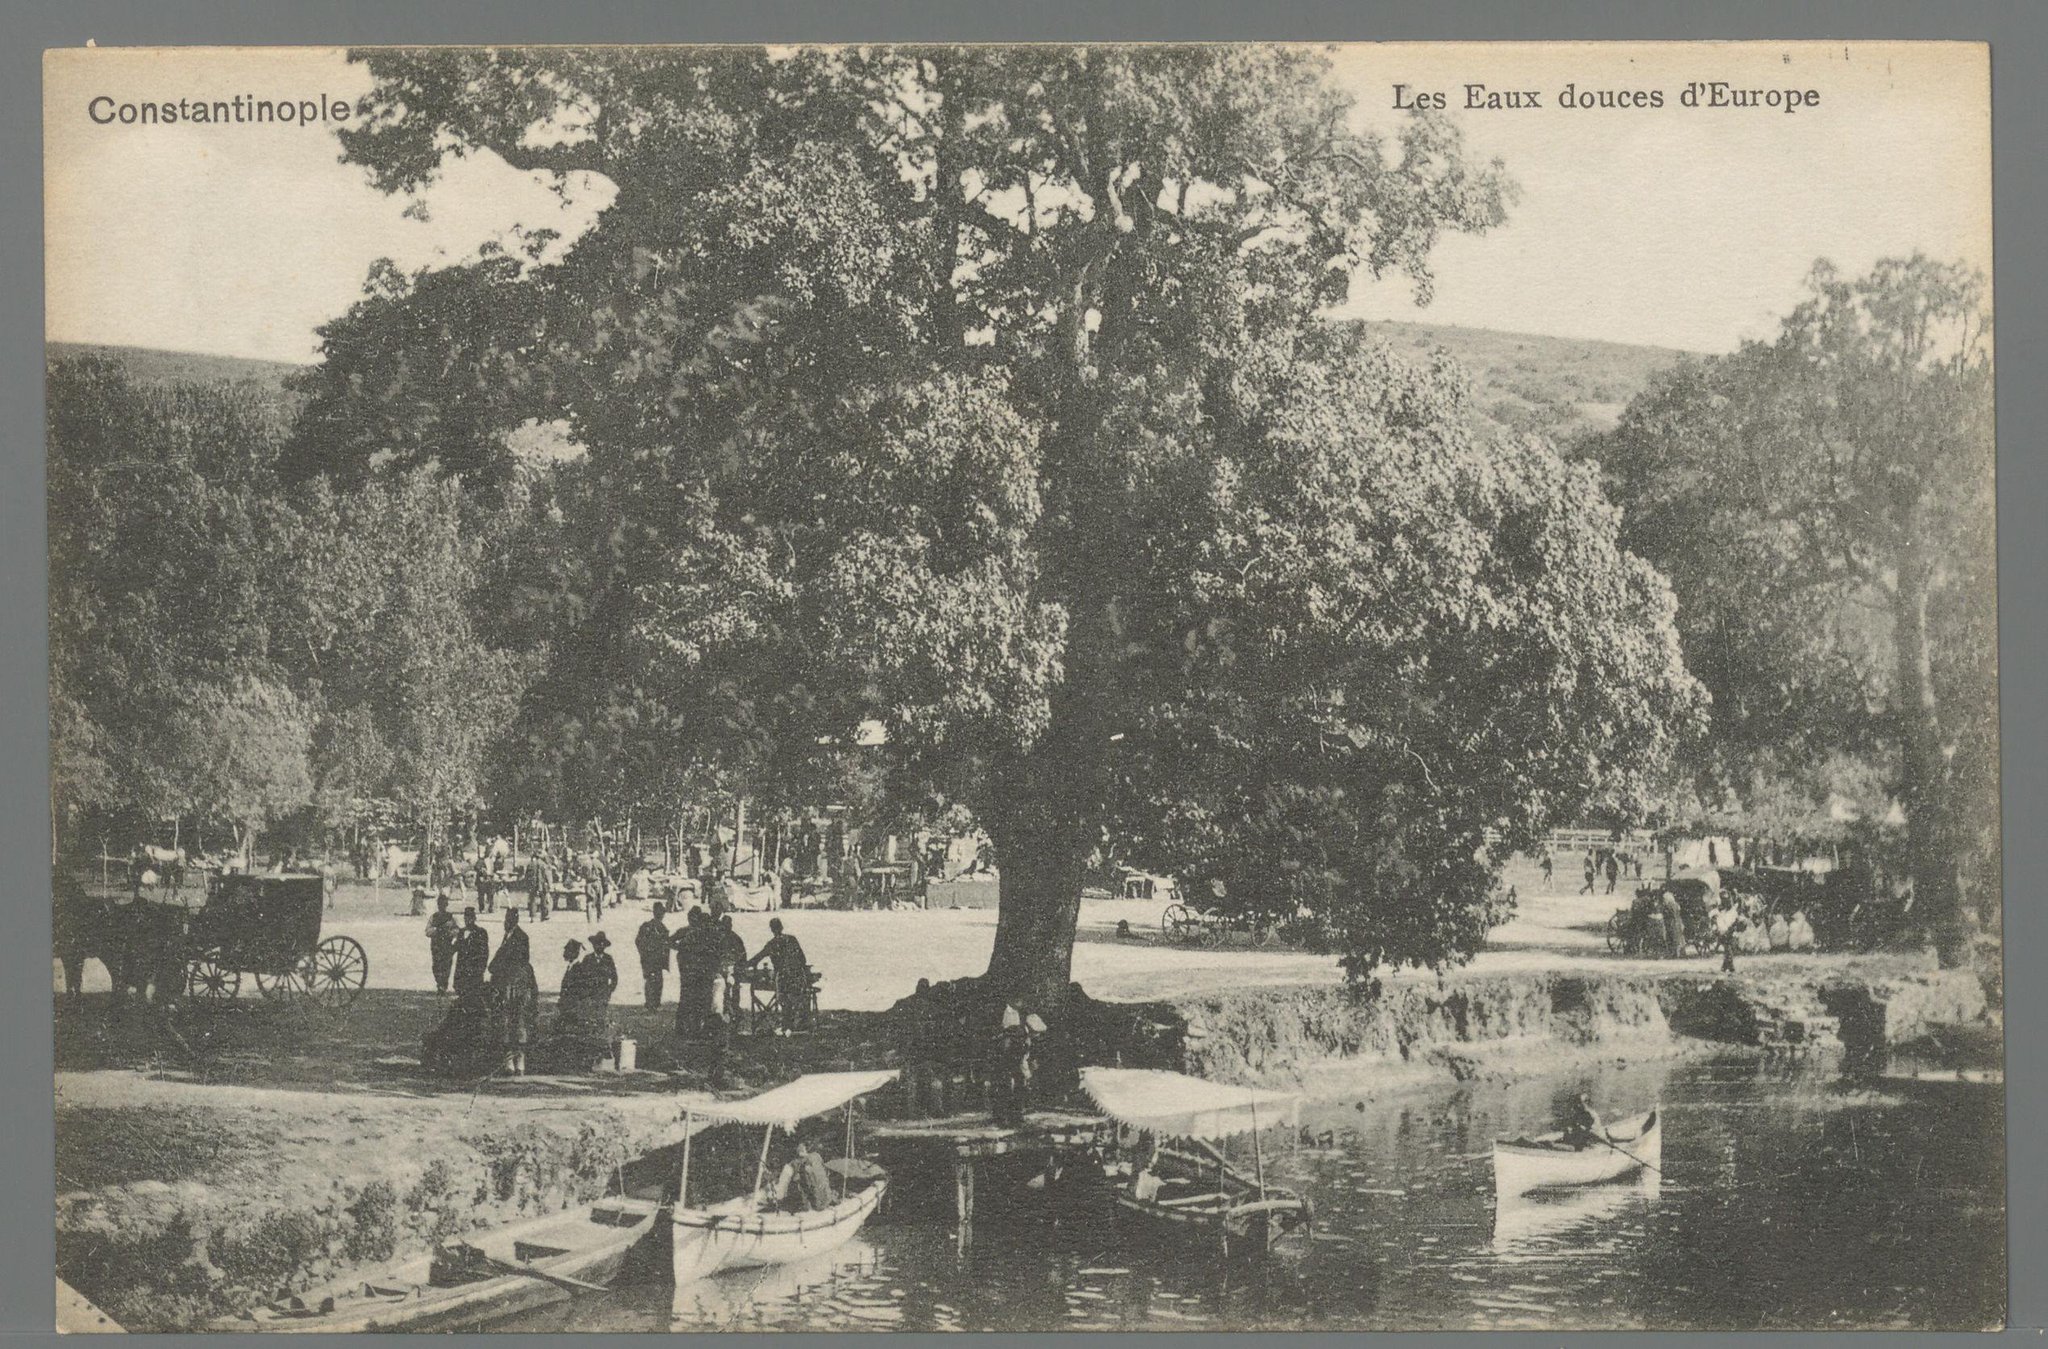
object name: photomechanical print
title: Constantinople. Les Eaux douces d'Europe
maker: Anonymous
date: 1906-1920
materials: cardboard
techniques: photograph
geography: constantinople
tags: trees, public gardens, park (+ city(-scape) with figures, staffage), rowing-boat, canoe, etc.